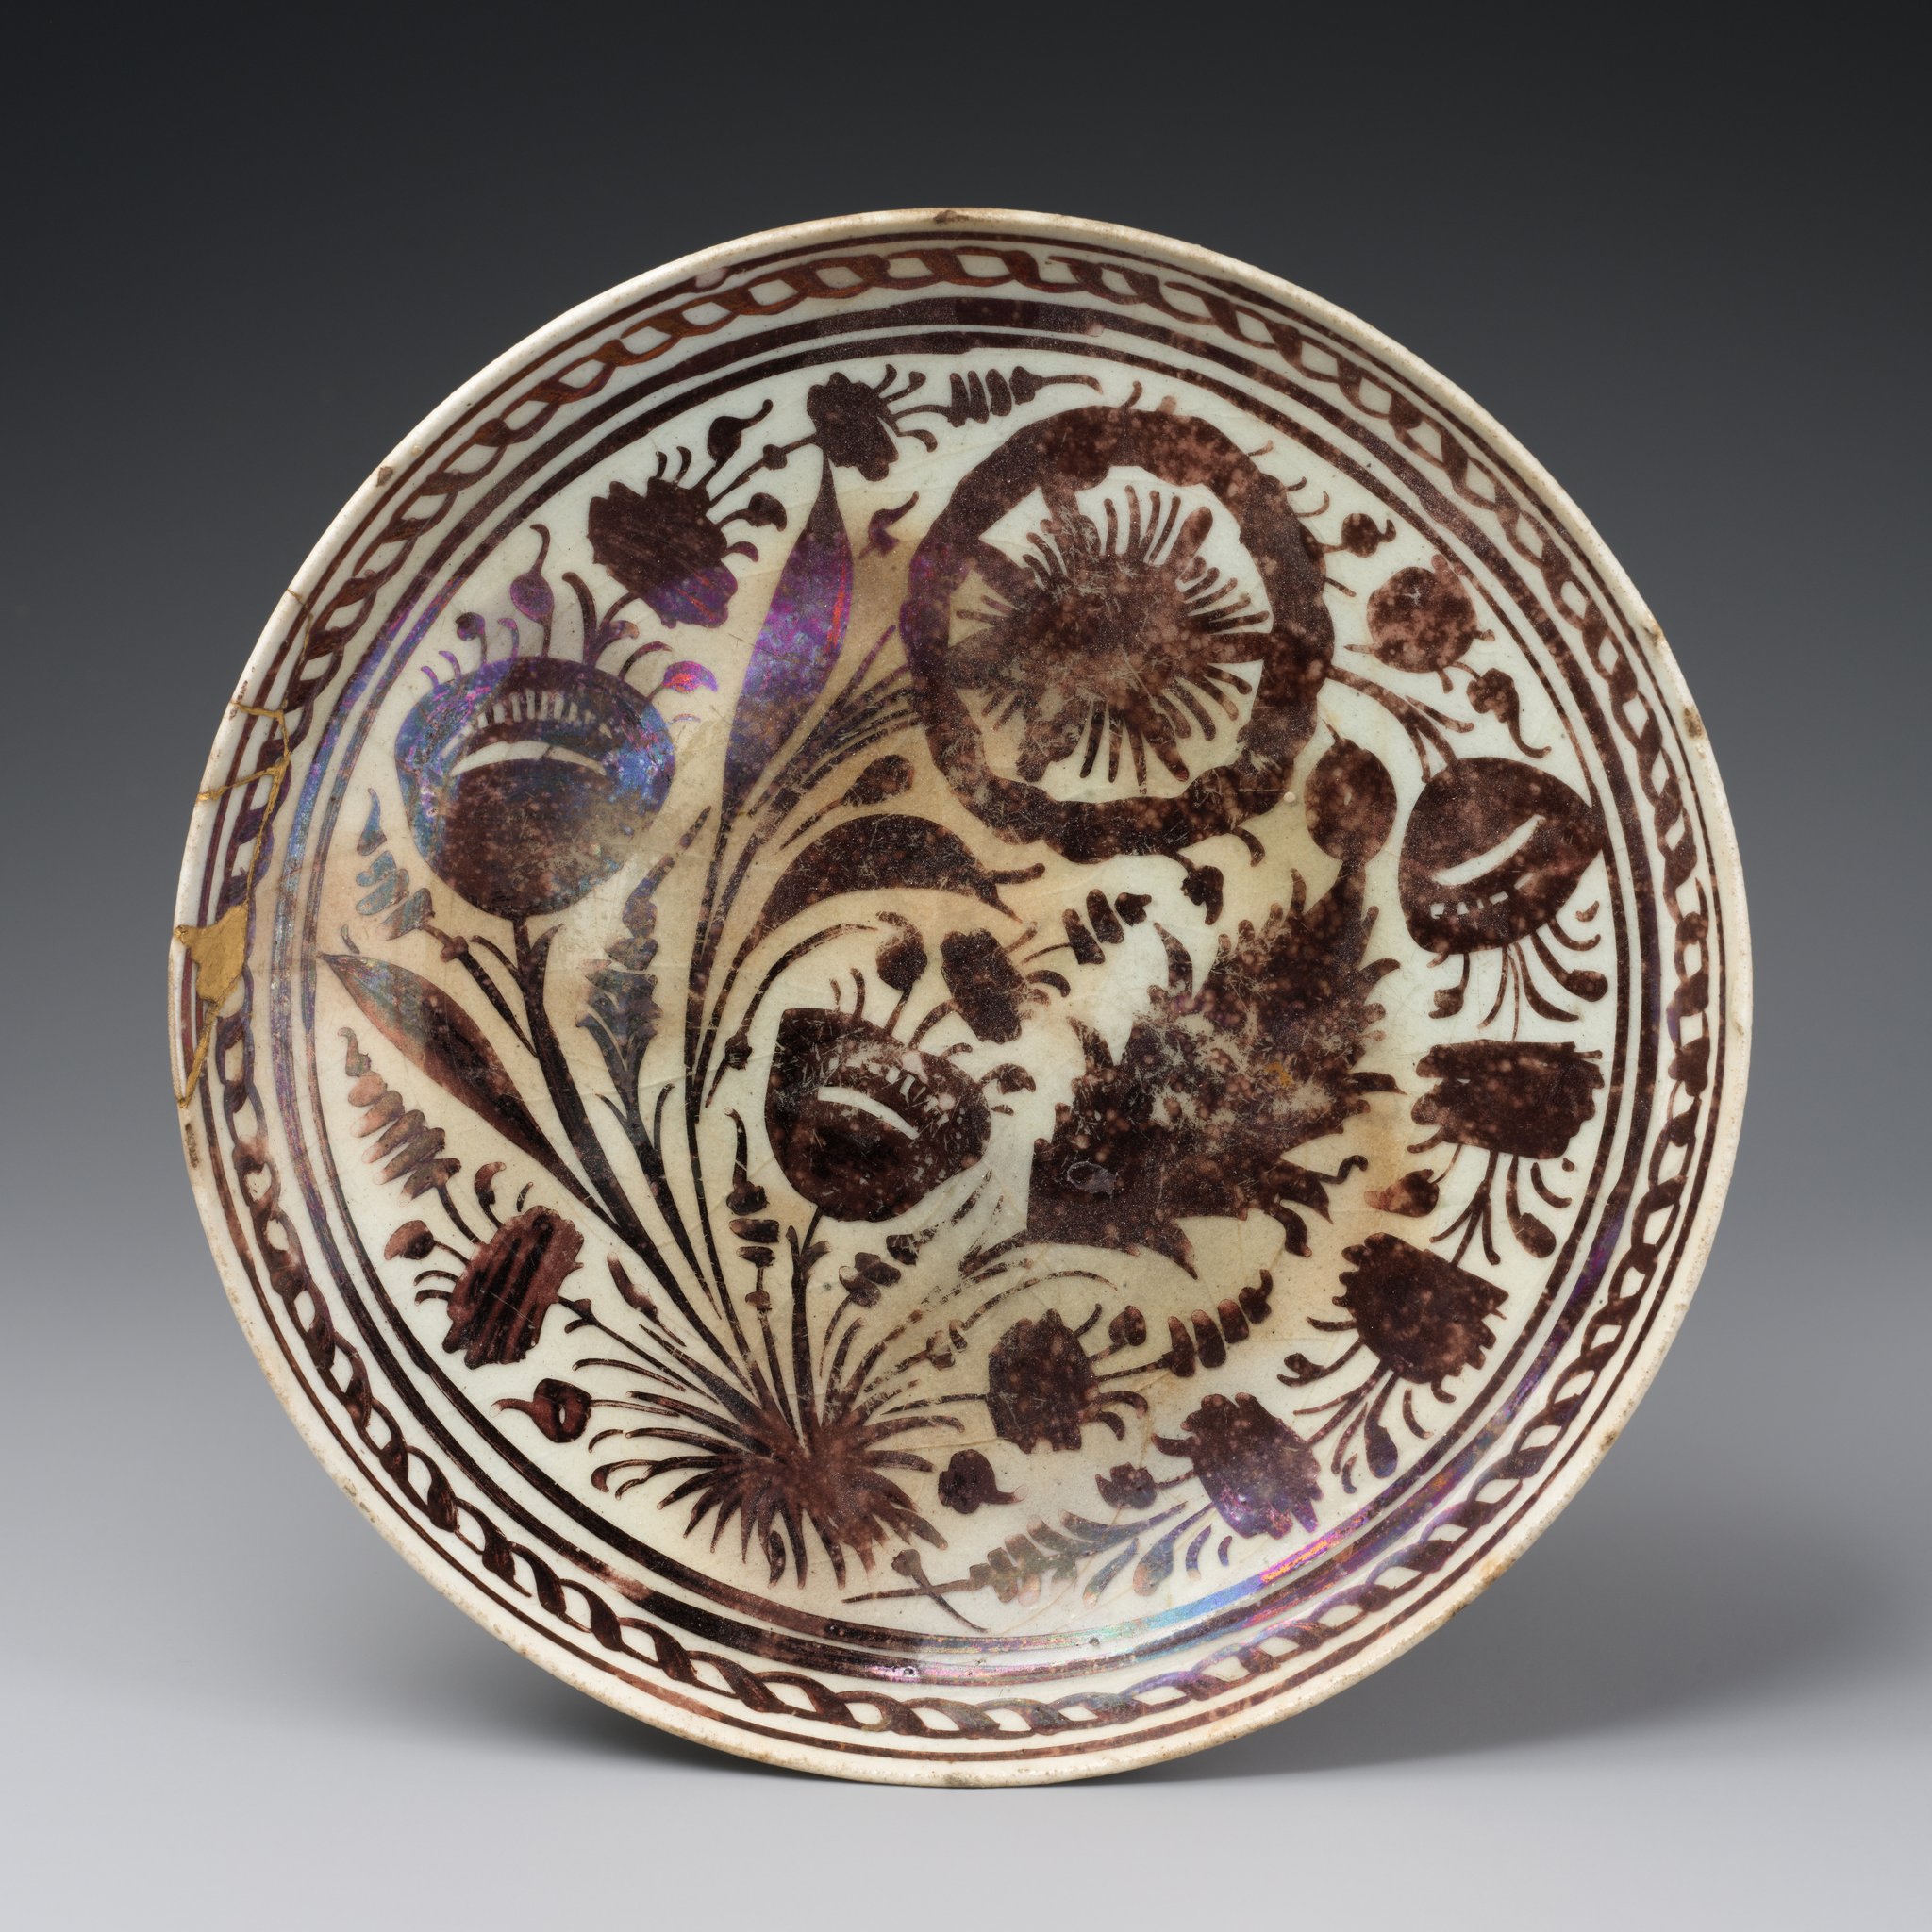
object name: dish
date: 1601-1700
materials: glaze, stonepaste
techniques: luster painting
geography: iran